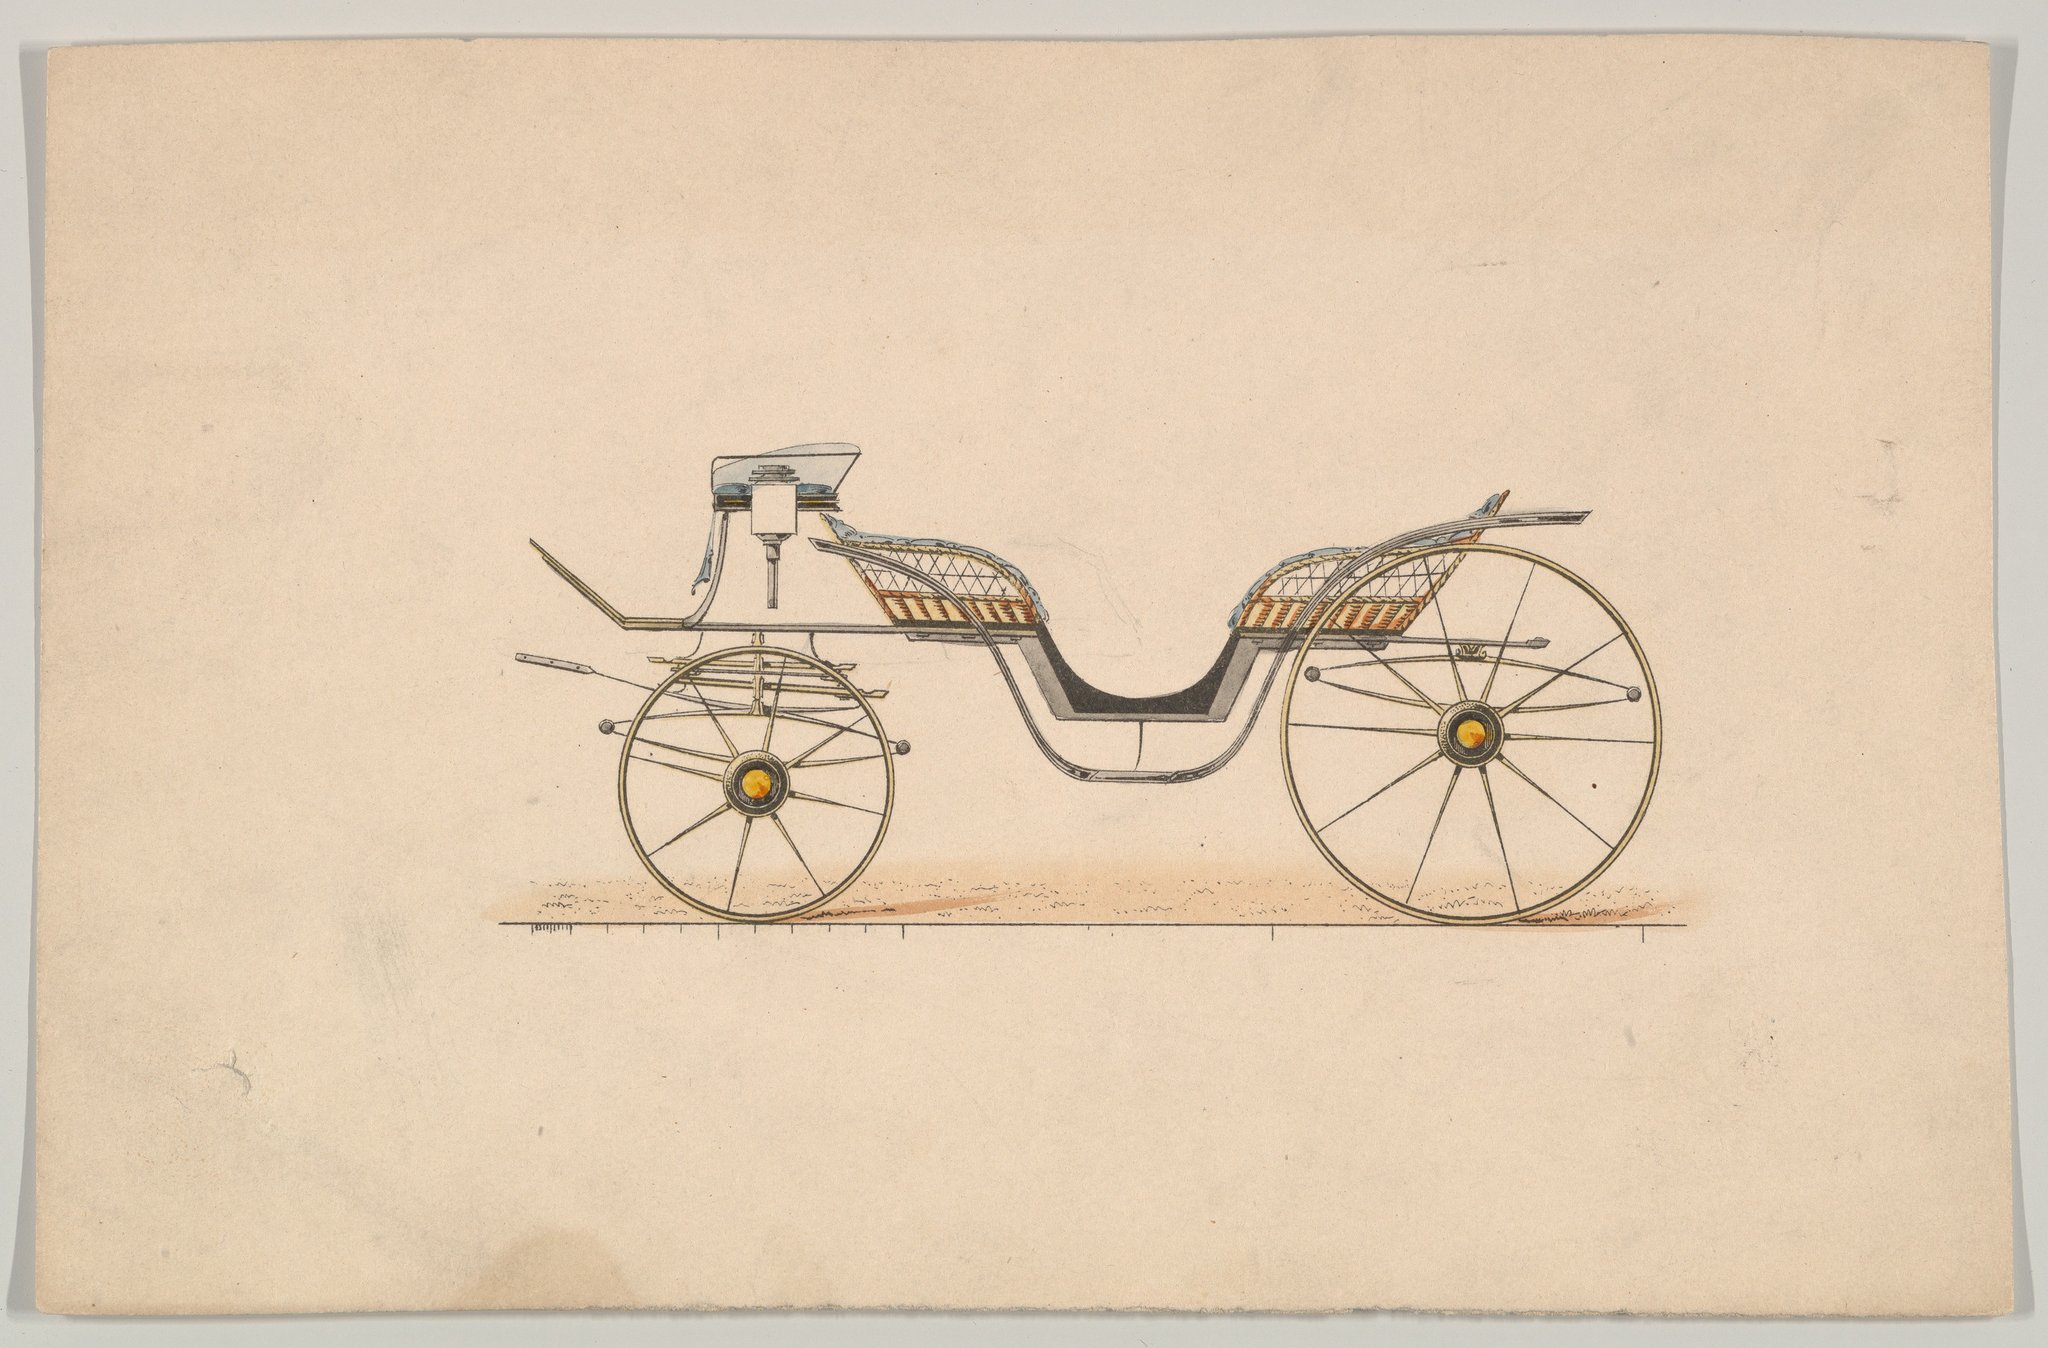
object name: drawing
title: Design for Vis-à-vis (unnumbered)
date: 1850-1870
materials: gouache, watercolor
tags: carriages